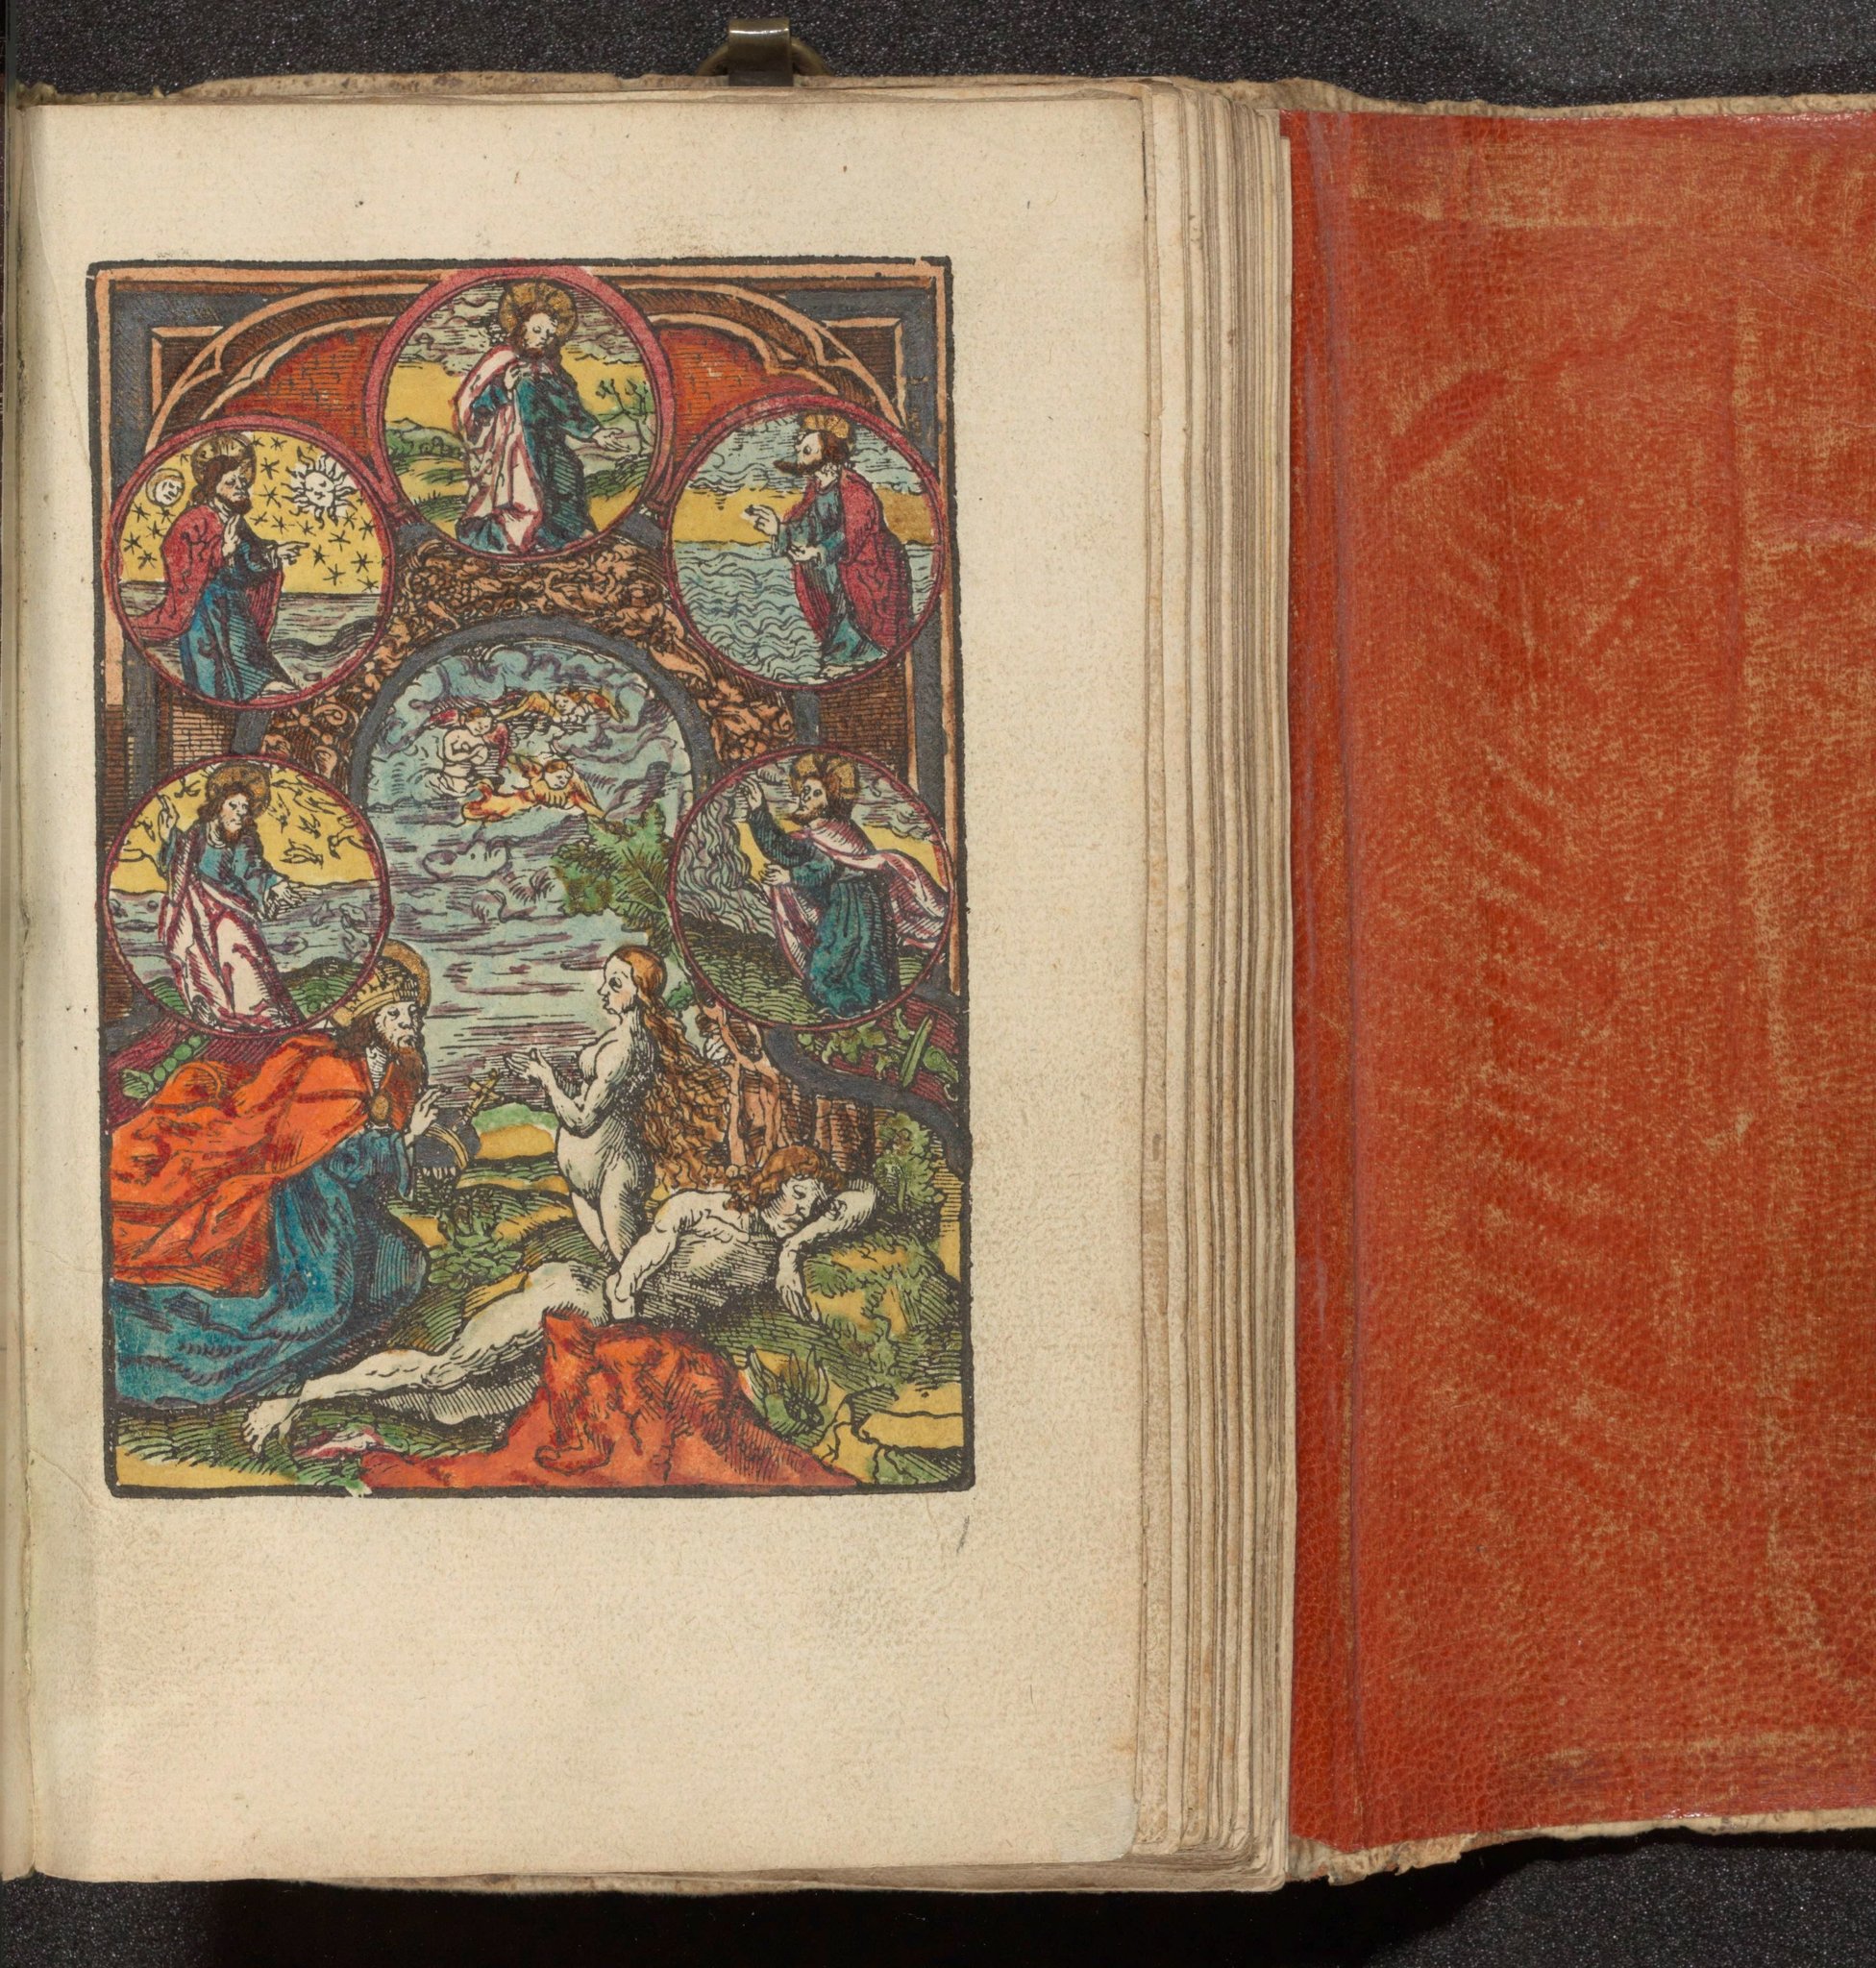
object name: album leaf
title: Schepping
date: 1530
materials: paper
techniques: hand coloring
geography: amsterdam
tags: god the creator, book in which illustrations are essential, creation of eve, the six days of creation (genesis 1:3-25)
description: De zes dagen van de schepping verbeeld. Centraal staat de zesde dag, waarop God de mens schiep. God de Vader staat met een wereldbol in de hand en schept Eva uit de rib van de slapende Adam. In de cirkels voorstellingen van God de Vader en zijn scheppingen op de eerste tot en met de vijfde scheppingsdag. Prent maakt deel uit van een boek.